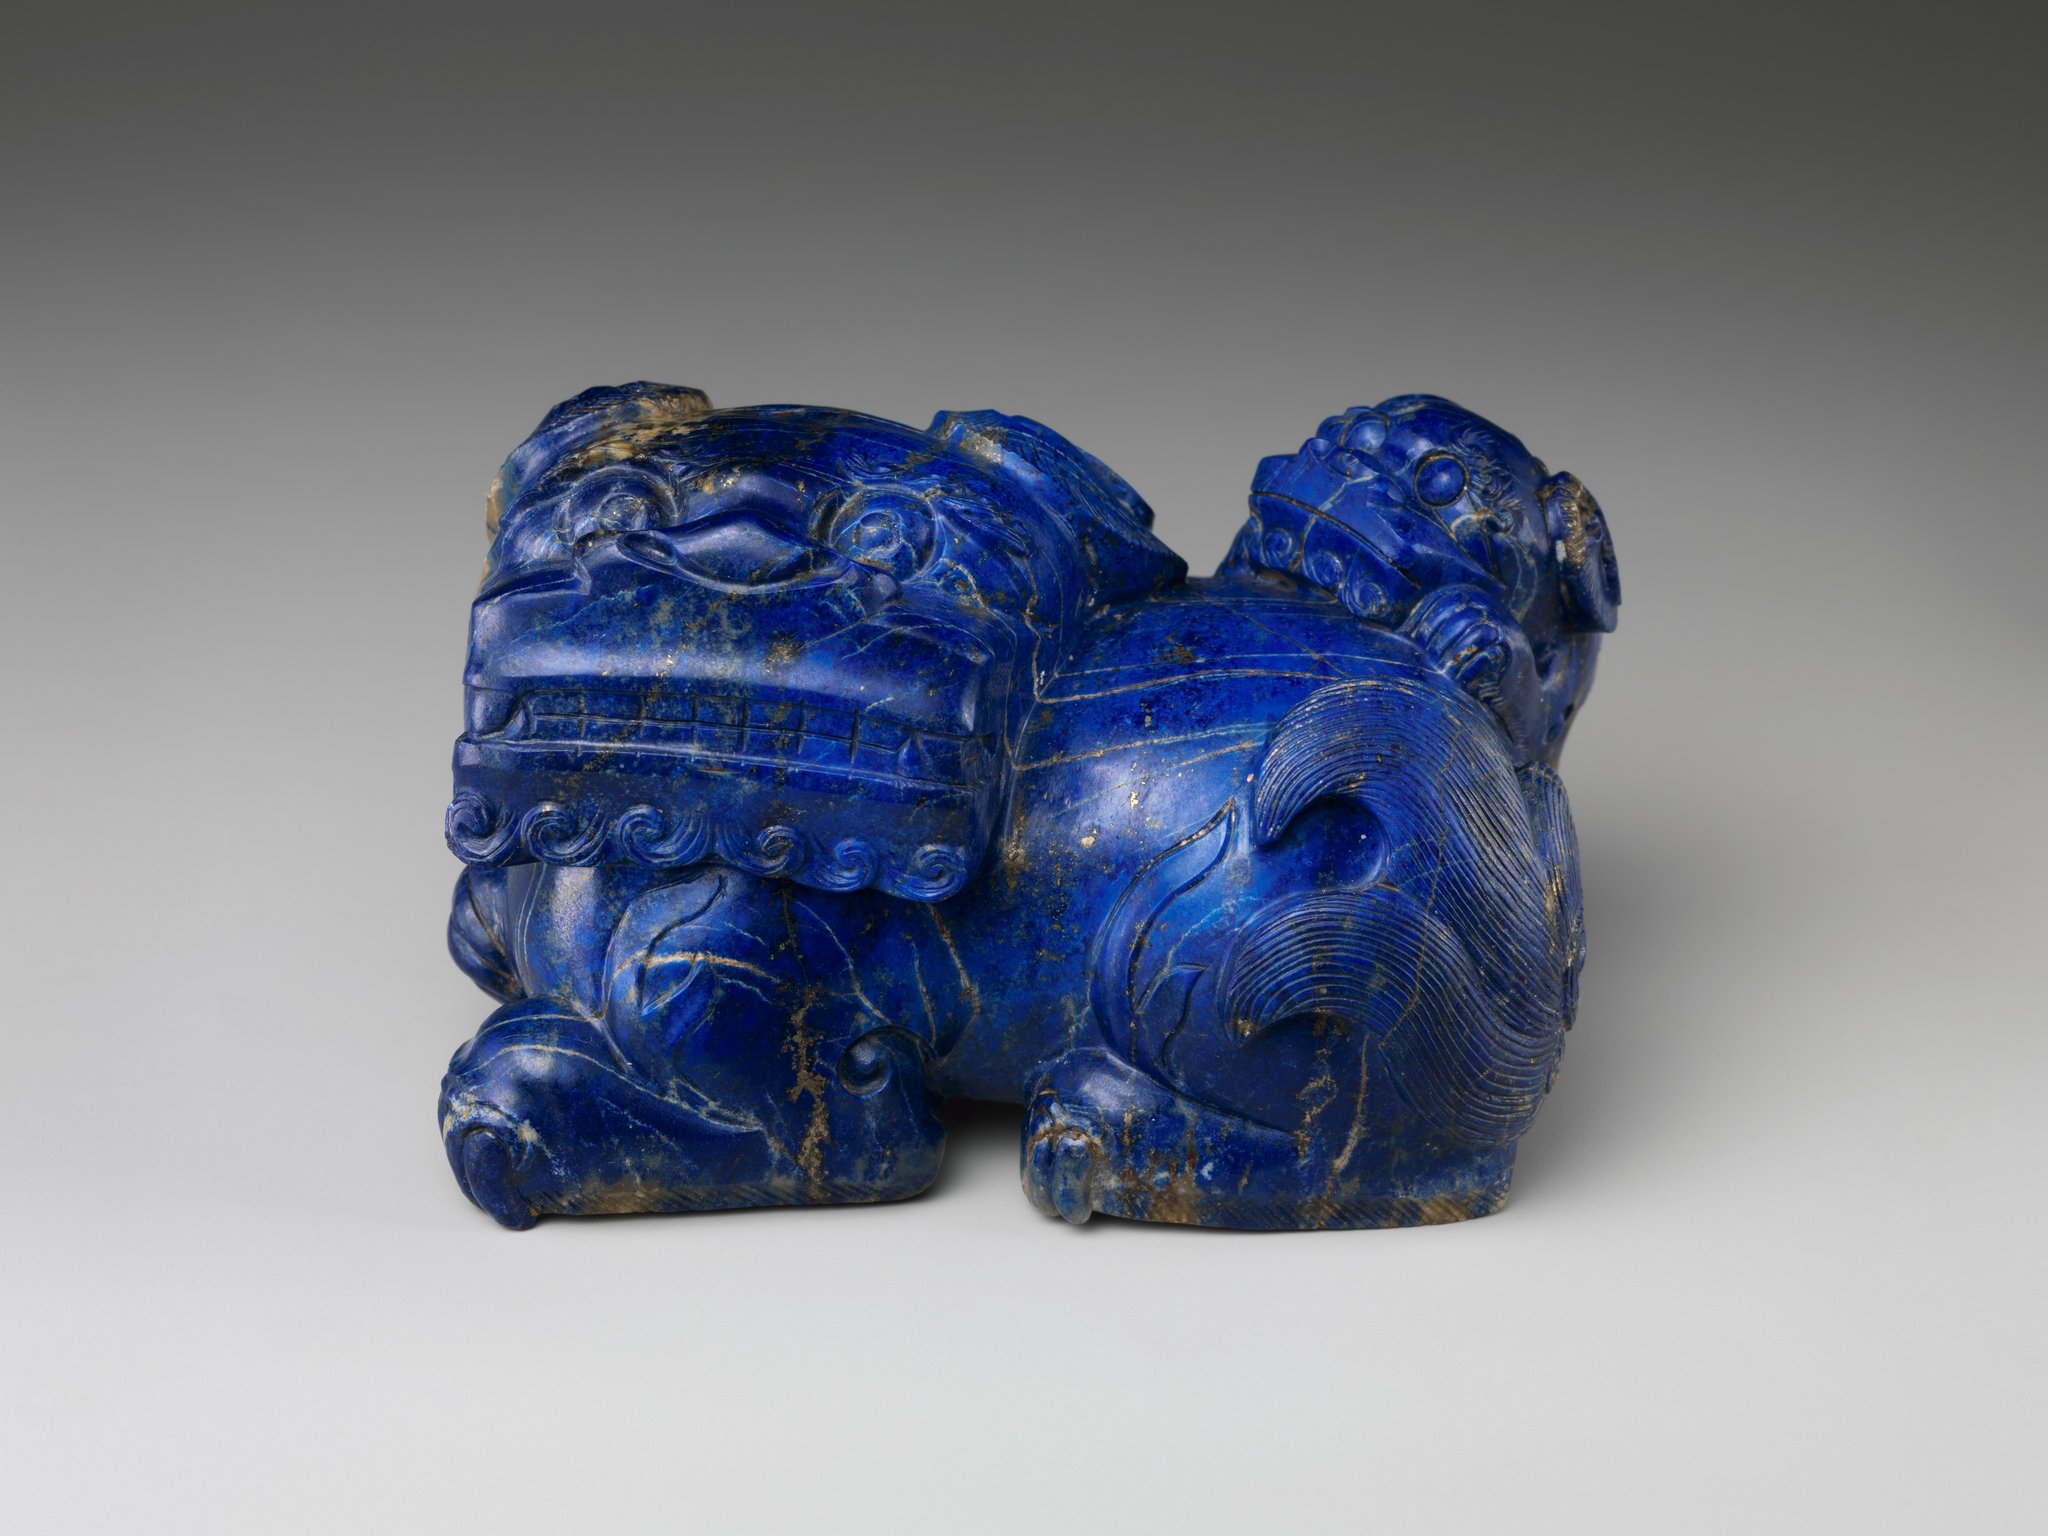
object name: figure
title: Lion and cub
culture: chinese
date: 1701-1800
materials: lapis lazuli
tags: lions